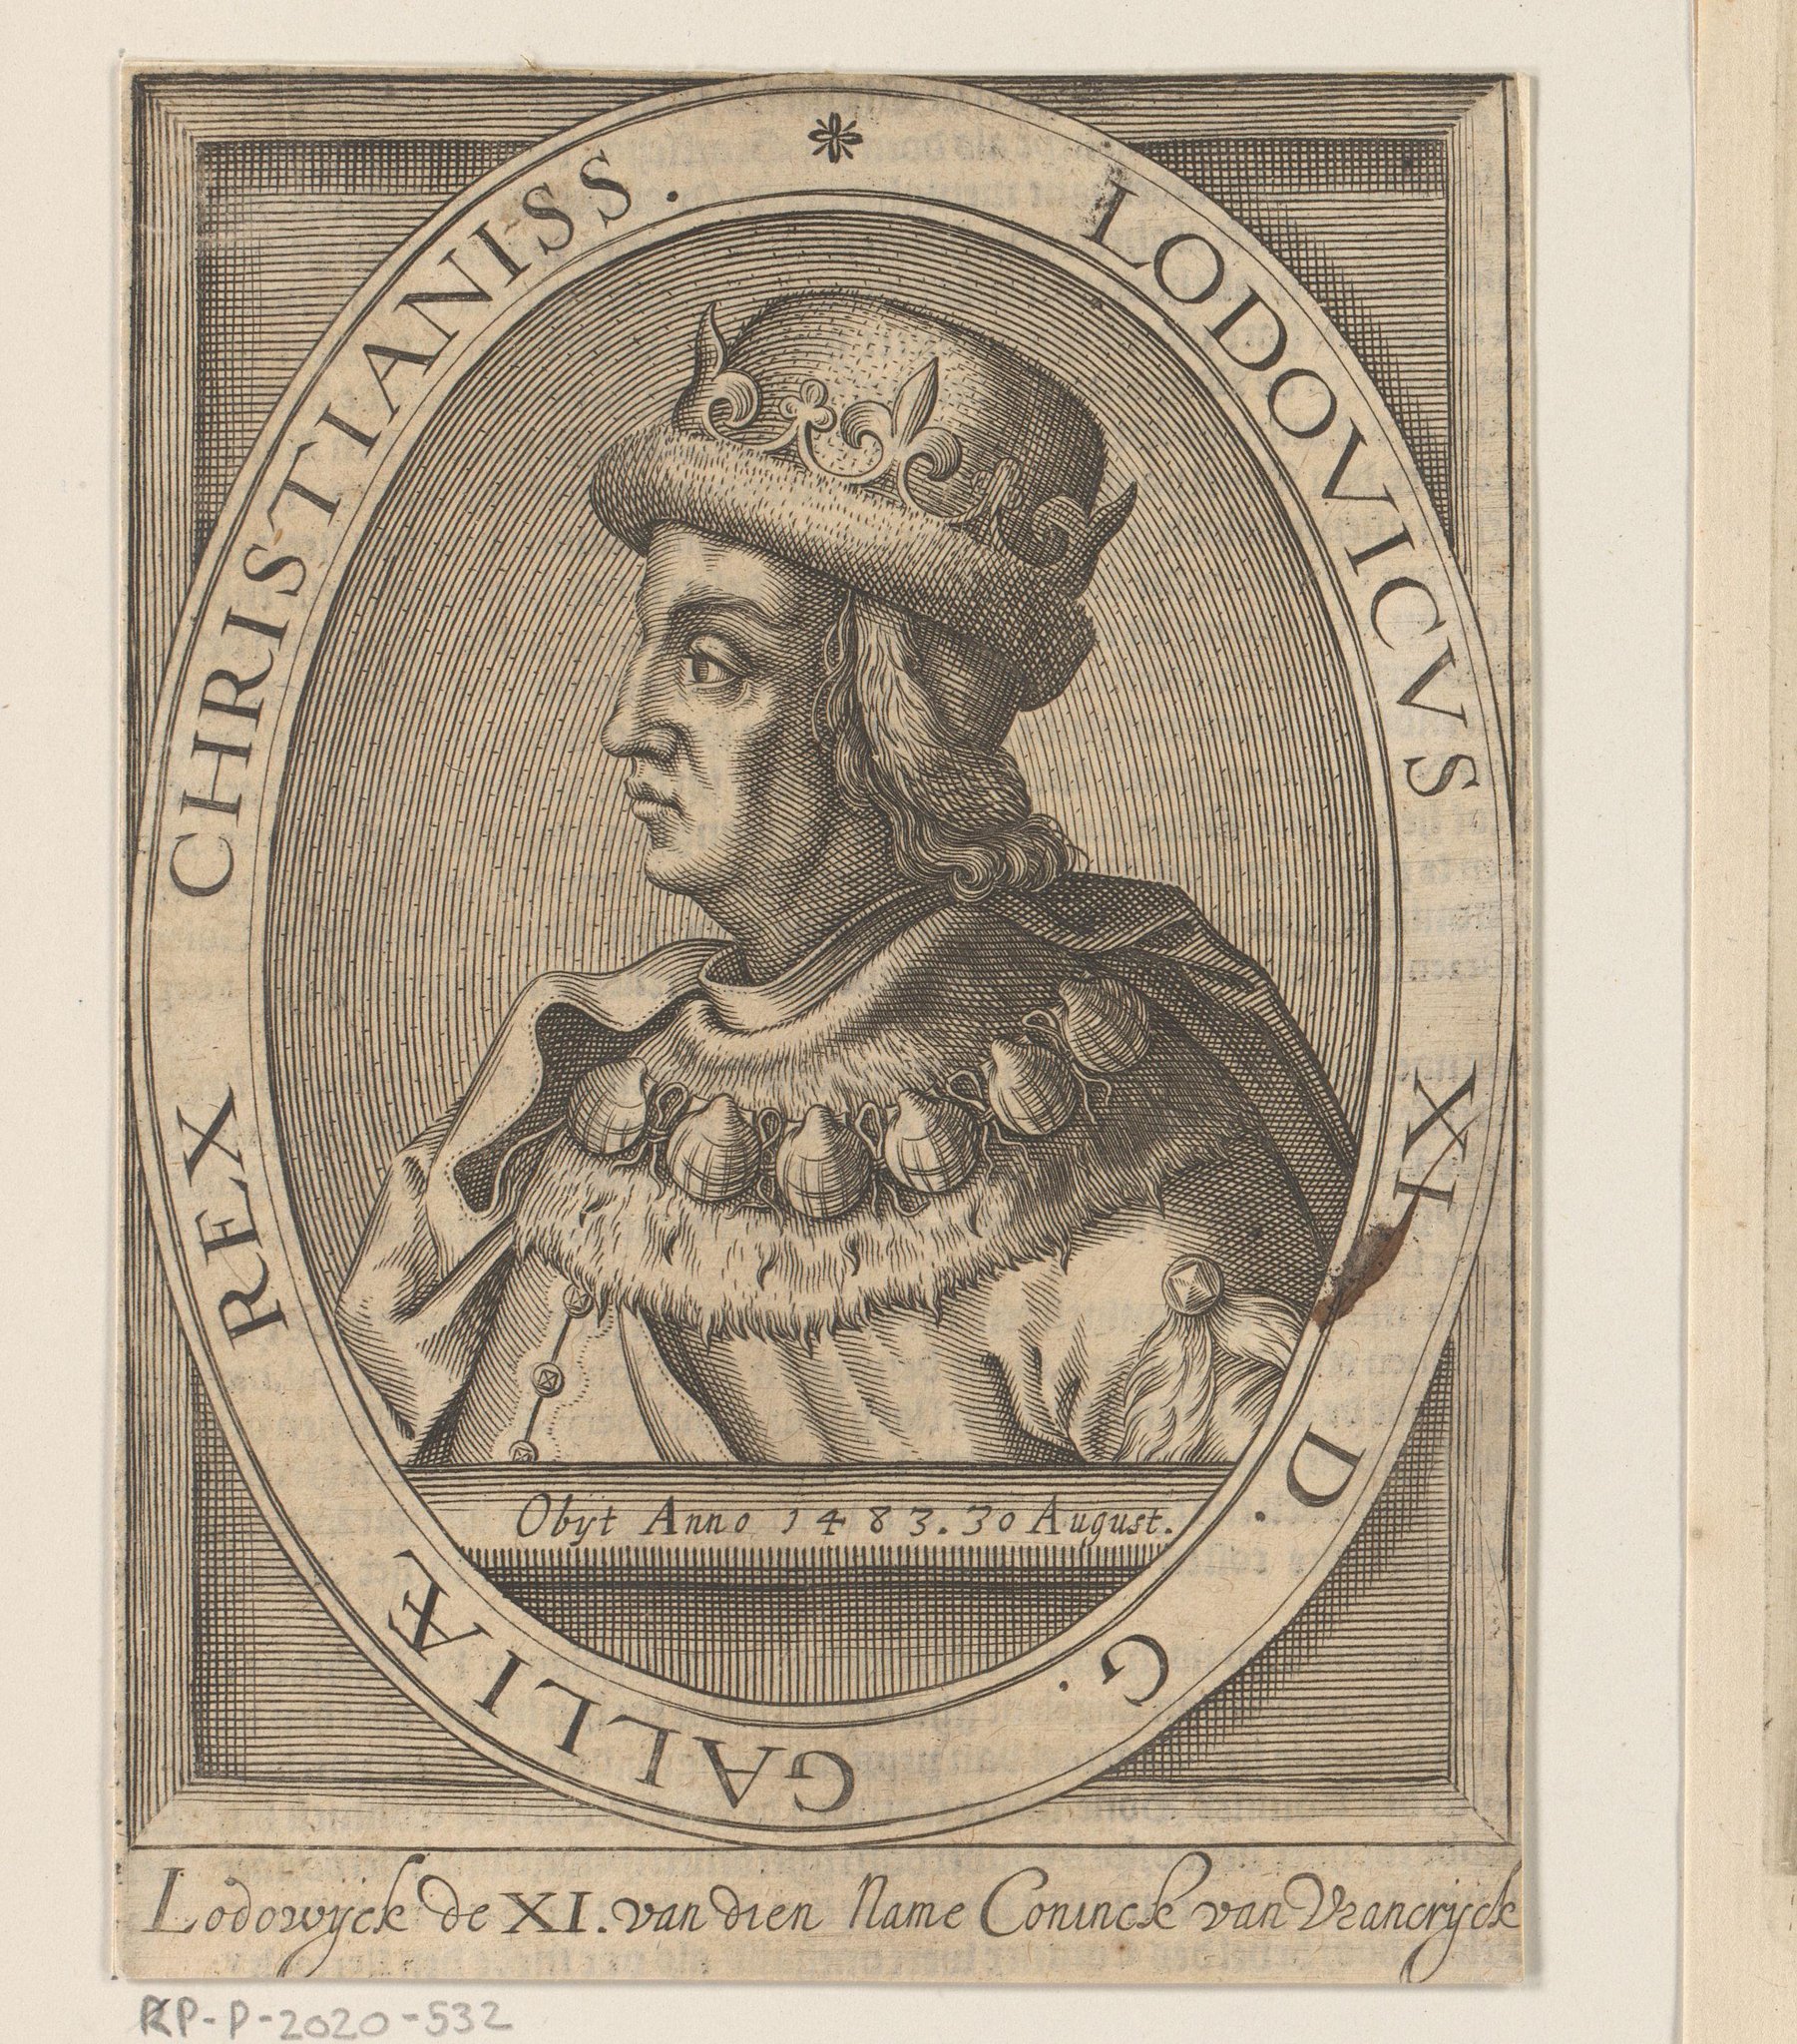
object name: print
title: Lodovicus XI D. G. Galliae rex Christianiss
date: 1615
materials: paper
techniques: engraving, letterpress printing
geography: arnhem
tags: historical persons, king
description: Prent uit: Clerck, Nicolaes de. Tooneel der keyseren ende coningen van Christenryck sedert den onderganck van het Griecks keyserdom. Vervatende hare beeltenissen (...). Arnhem: Jan Jansz, 1615.